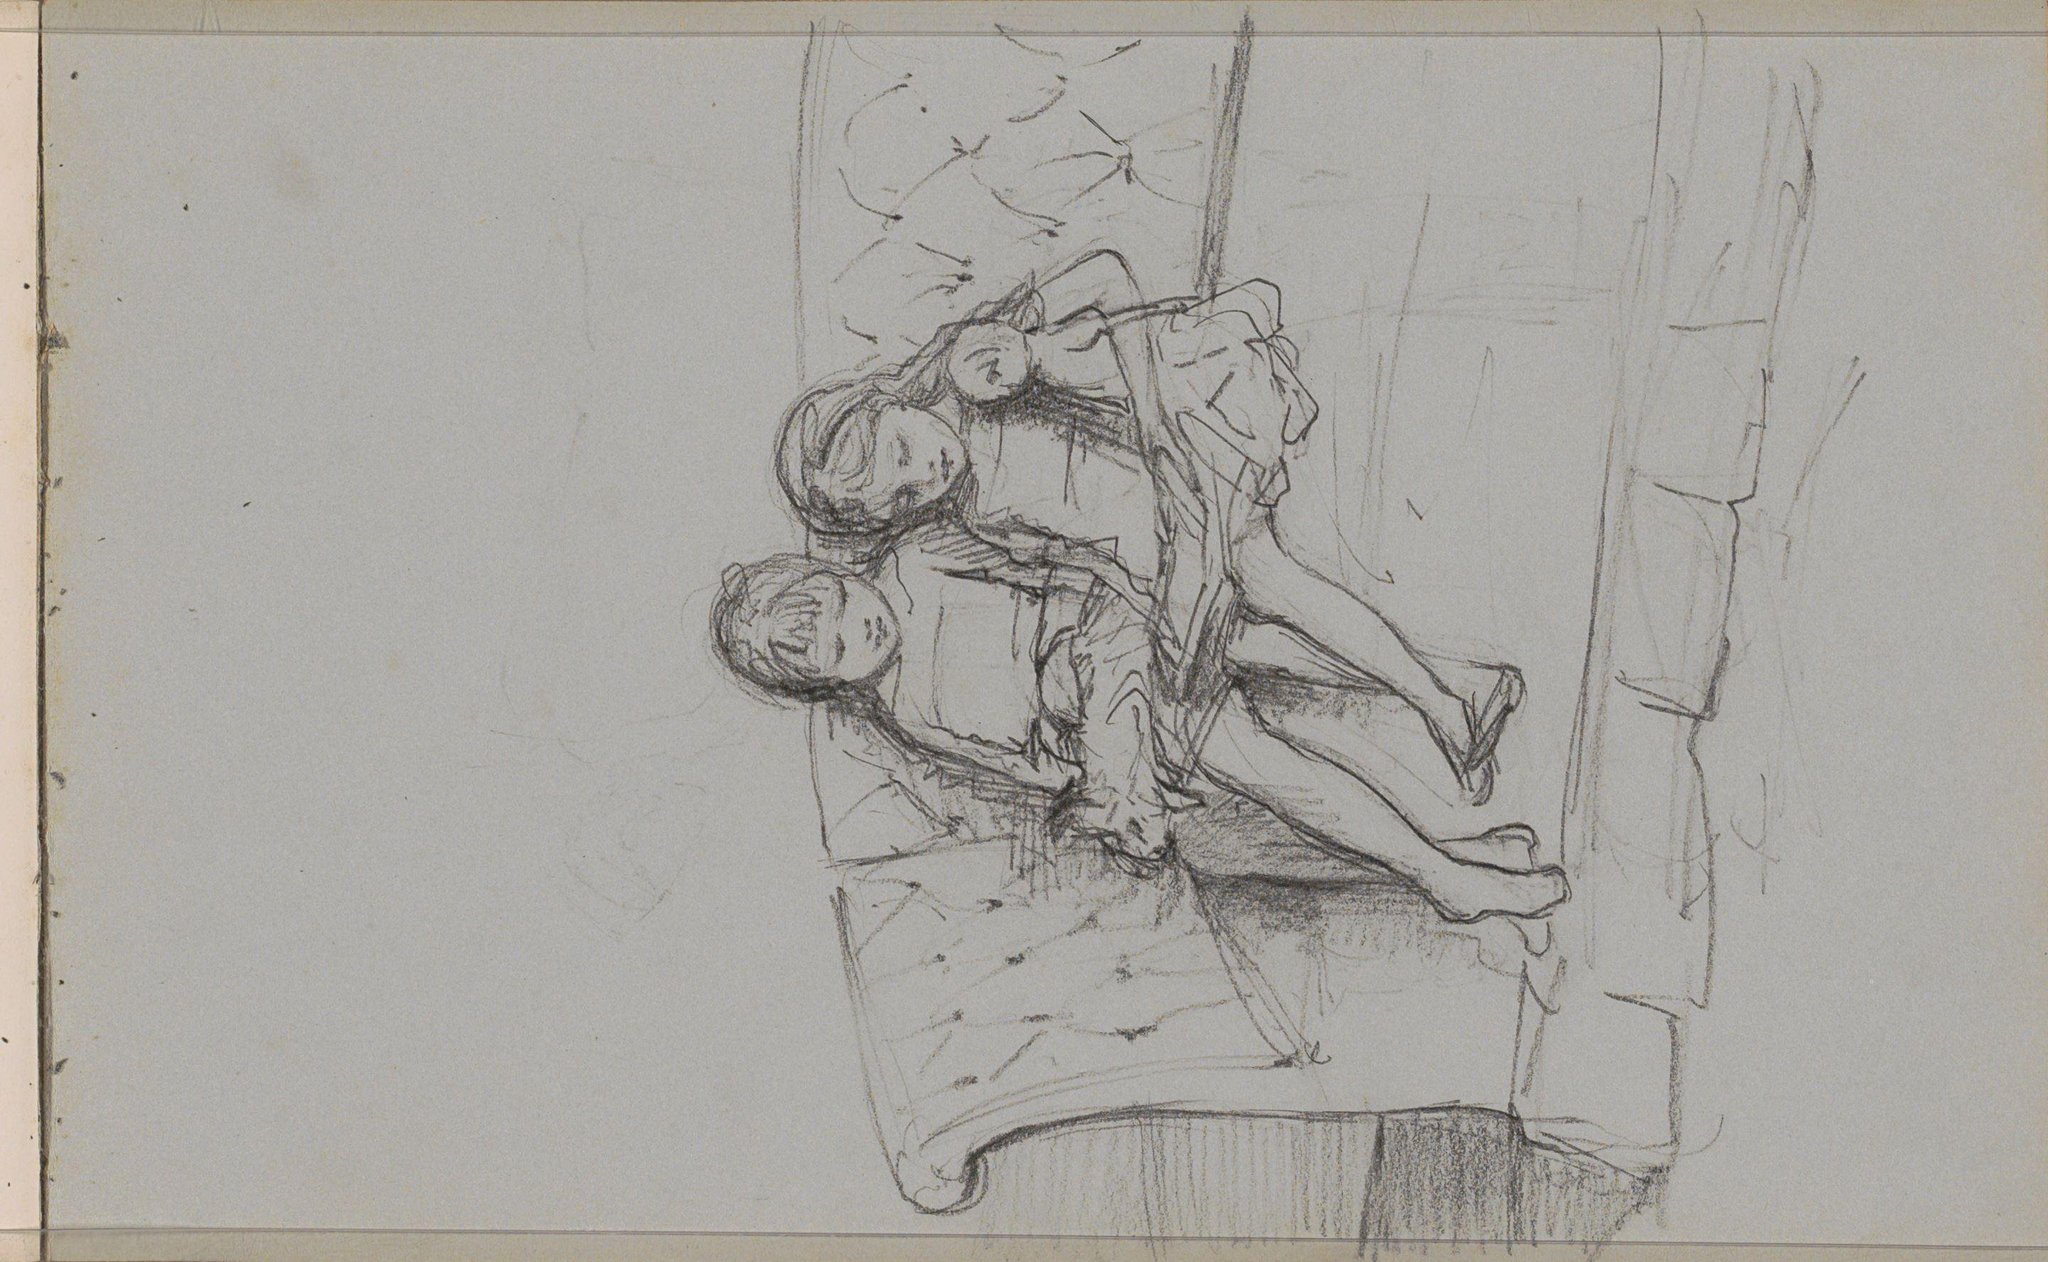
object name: sketchbook leaf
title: Twee lezende meisjes op een sofa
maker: a.a.l. de grammont-hubrecht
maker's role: draughtsman, painter, print maker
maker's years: 1855-1913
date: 1865-1913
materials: chalk, paper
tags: sitting figure, reading, girl (child between toddler and youth), (playing with) dolls, toy animals, couch, sofa, settee, rodents: rabbit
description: Het linkermeisje heeft een konijn op schoot, het rechtermeisje heeft een pop onder haar arm geklemd. Blad 18 recto uit een schetsboek met 28 bladen.